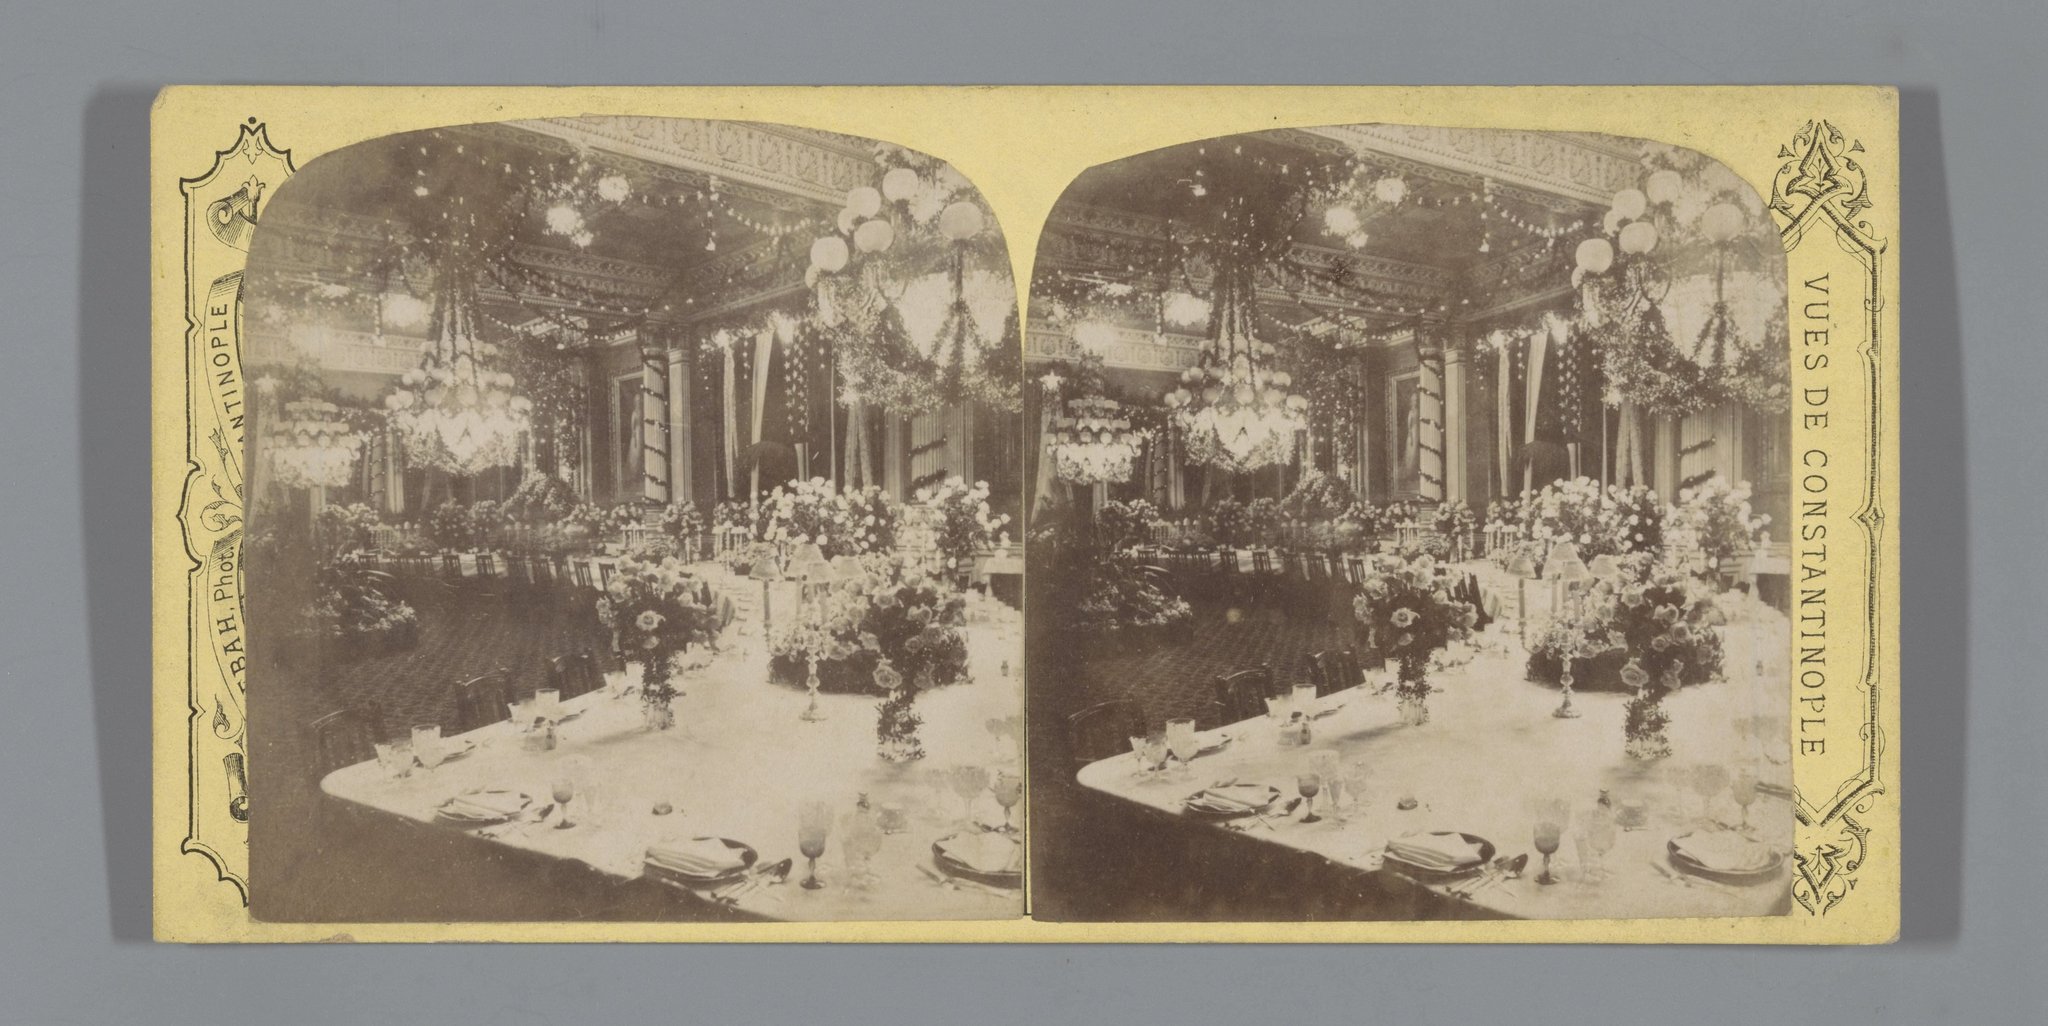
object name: stereograph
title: Feestzaal met gedekte tafels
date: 1888-1900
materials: cardboard, photographic support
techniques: albumen print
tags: celebration meal, feast, banquet, festivities, dining-room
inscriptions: : ‘Vues de Constantinople’